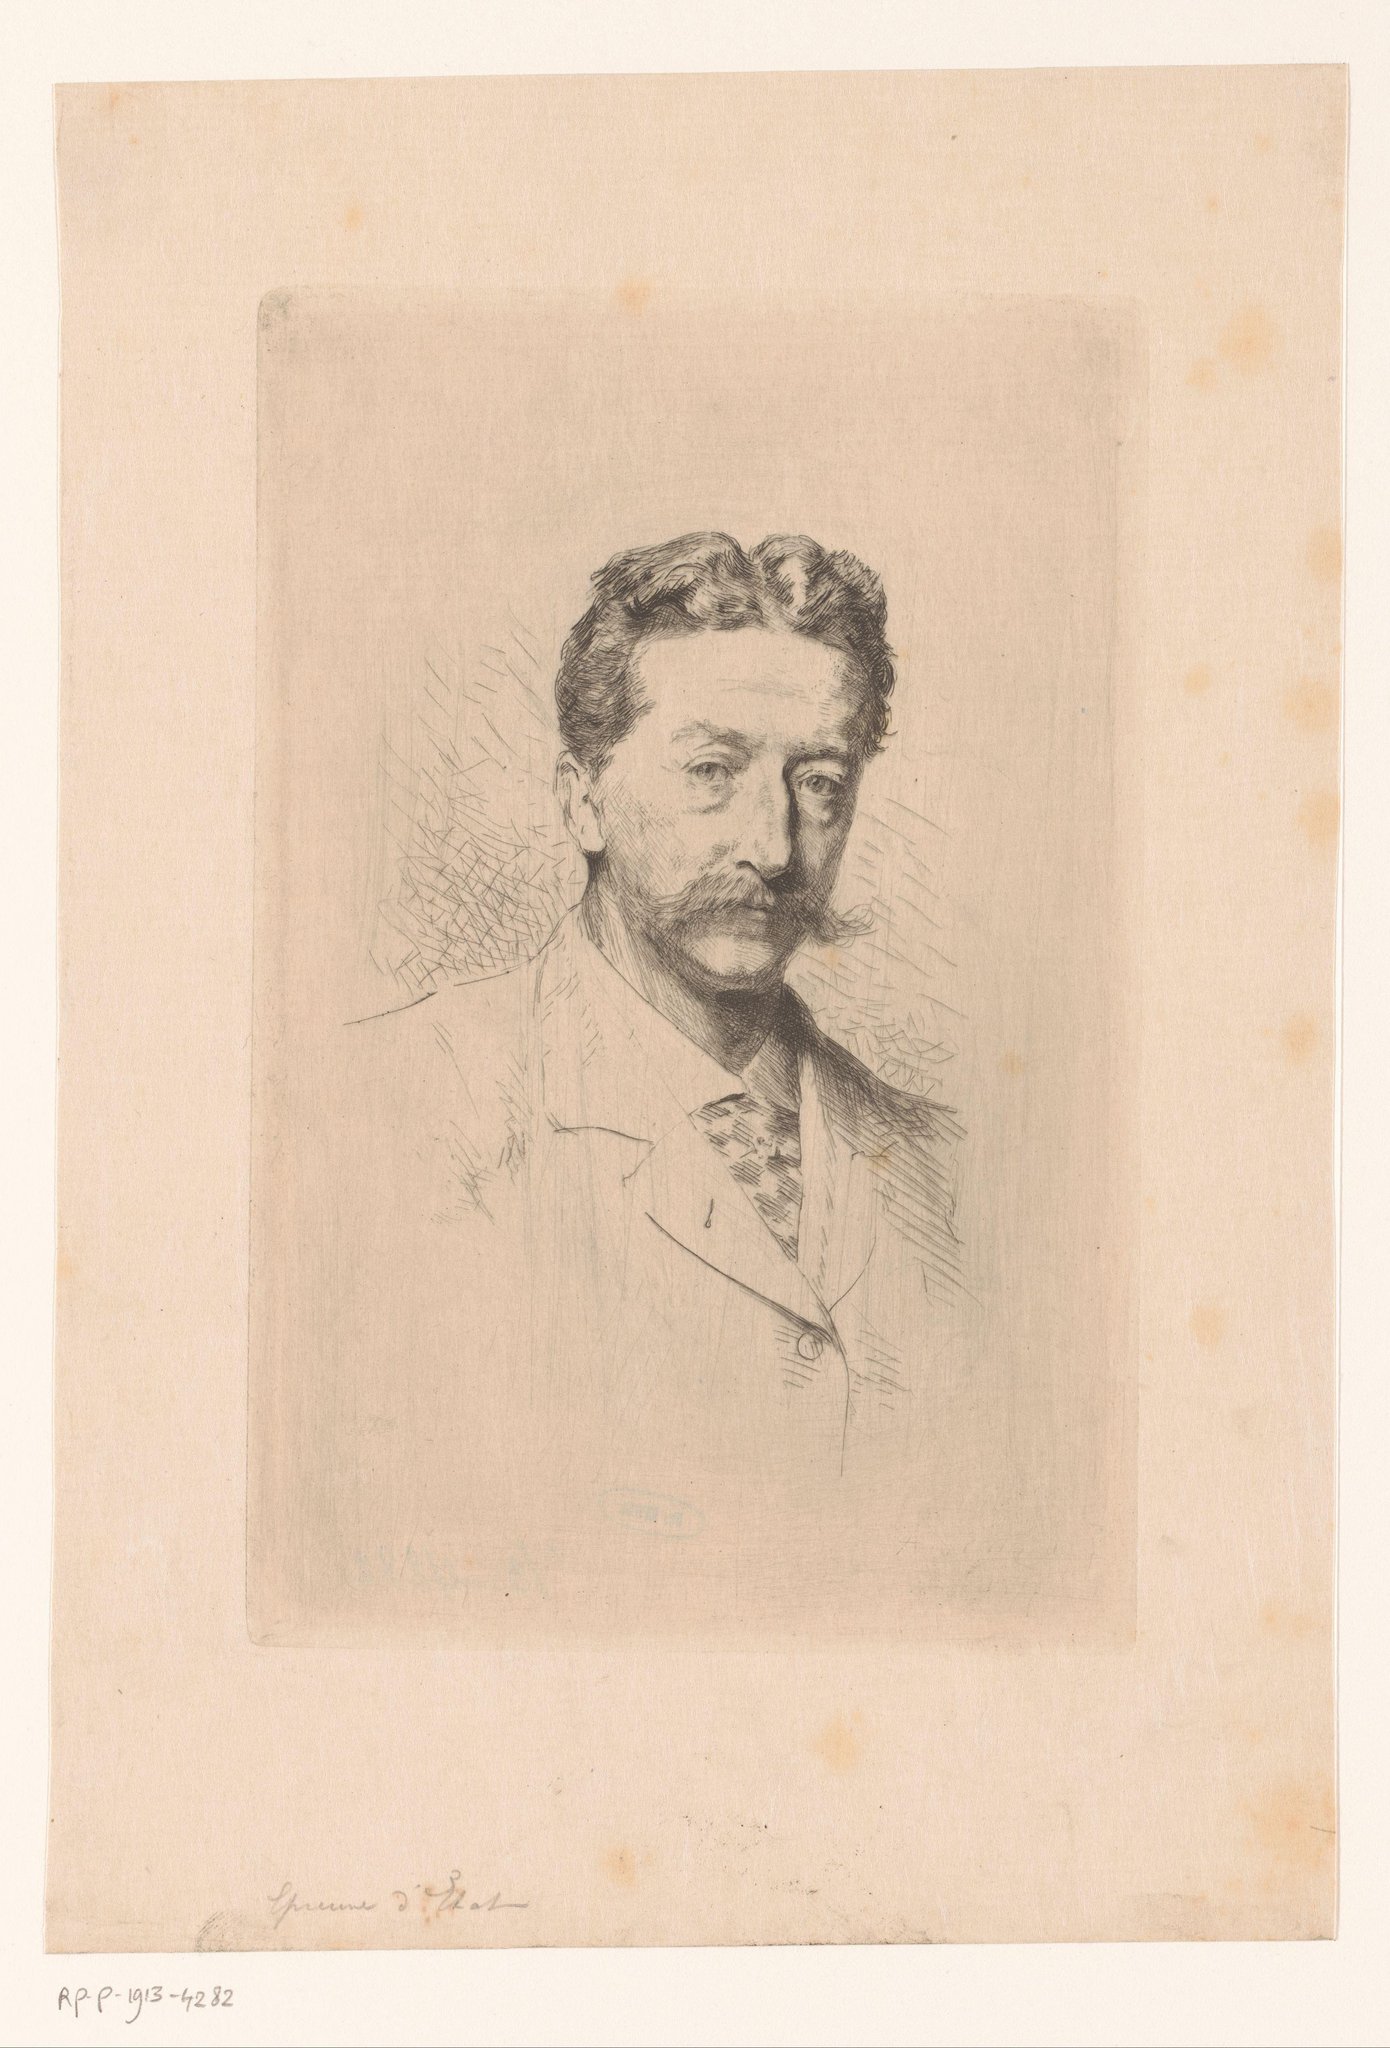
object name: print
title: Portret van Henri Orban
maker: adrien de witte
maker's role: print maker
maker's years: 1850-1935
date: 1877-1878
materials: paper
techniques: drypoint, etching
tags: moustache, adult man, historical persons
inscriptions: collector's mark: Lugt 2228